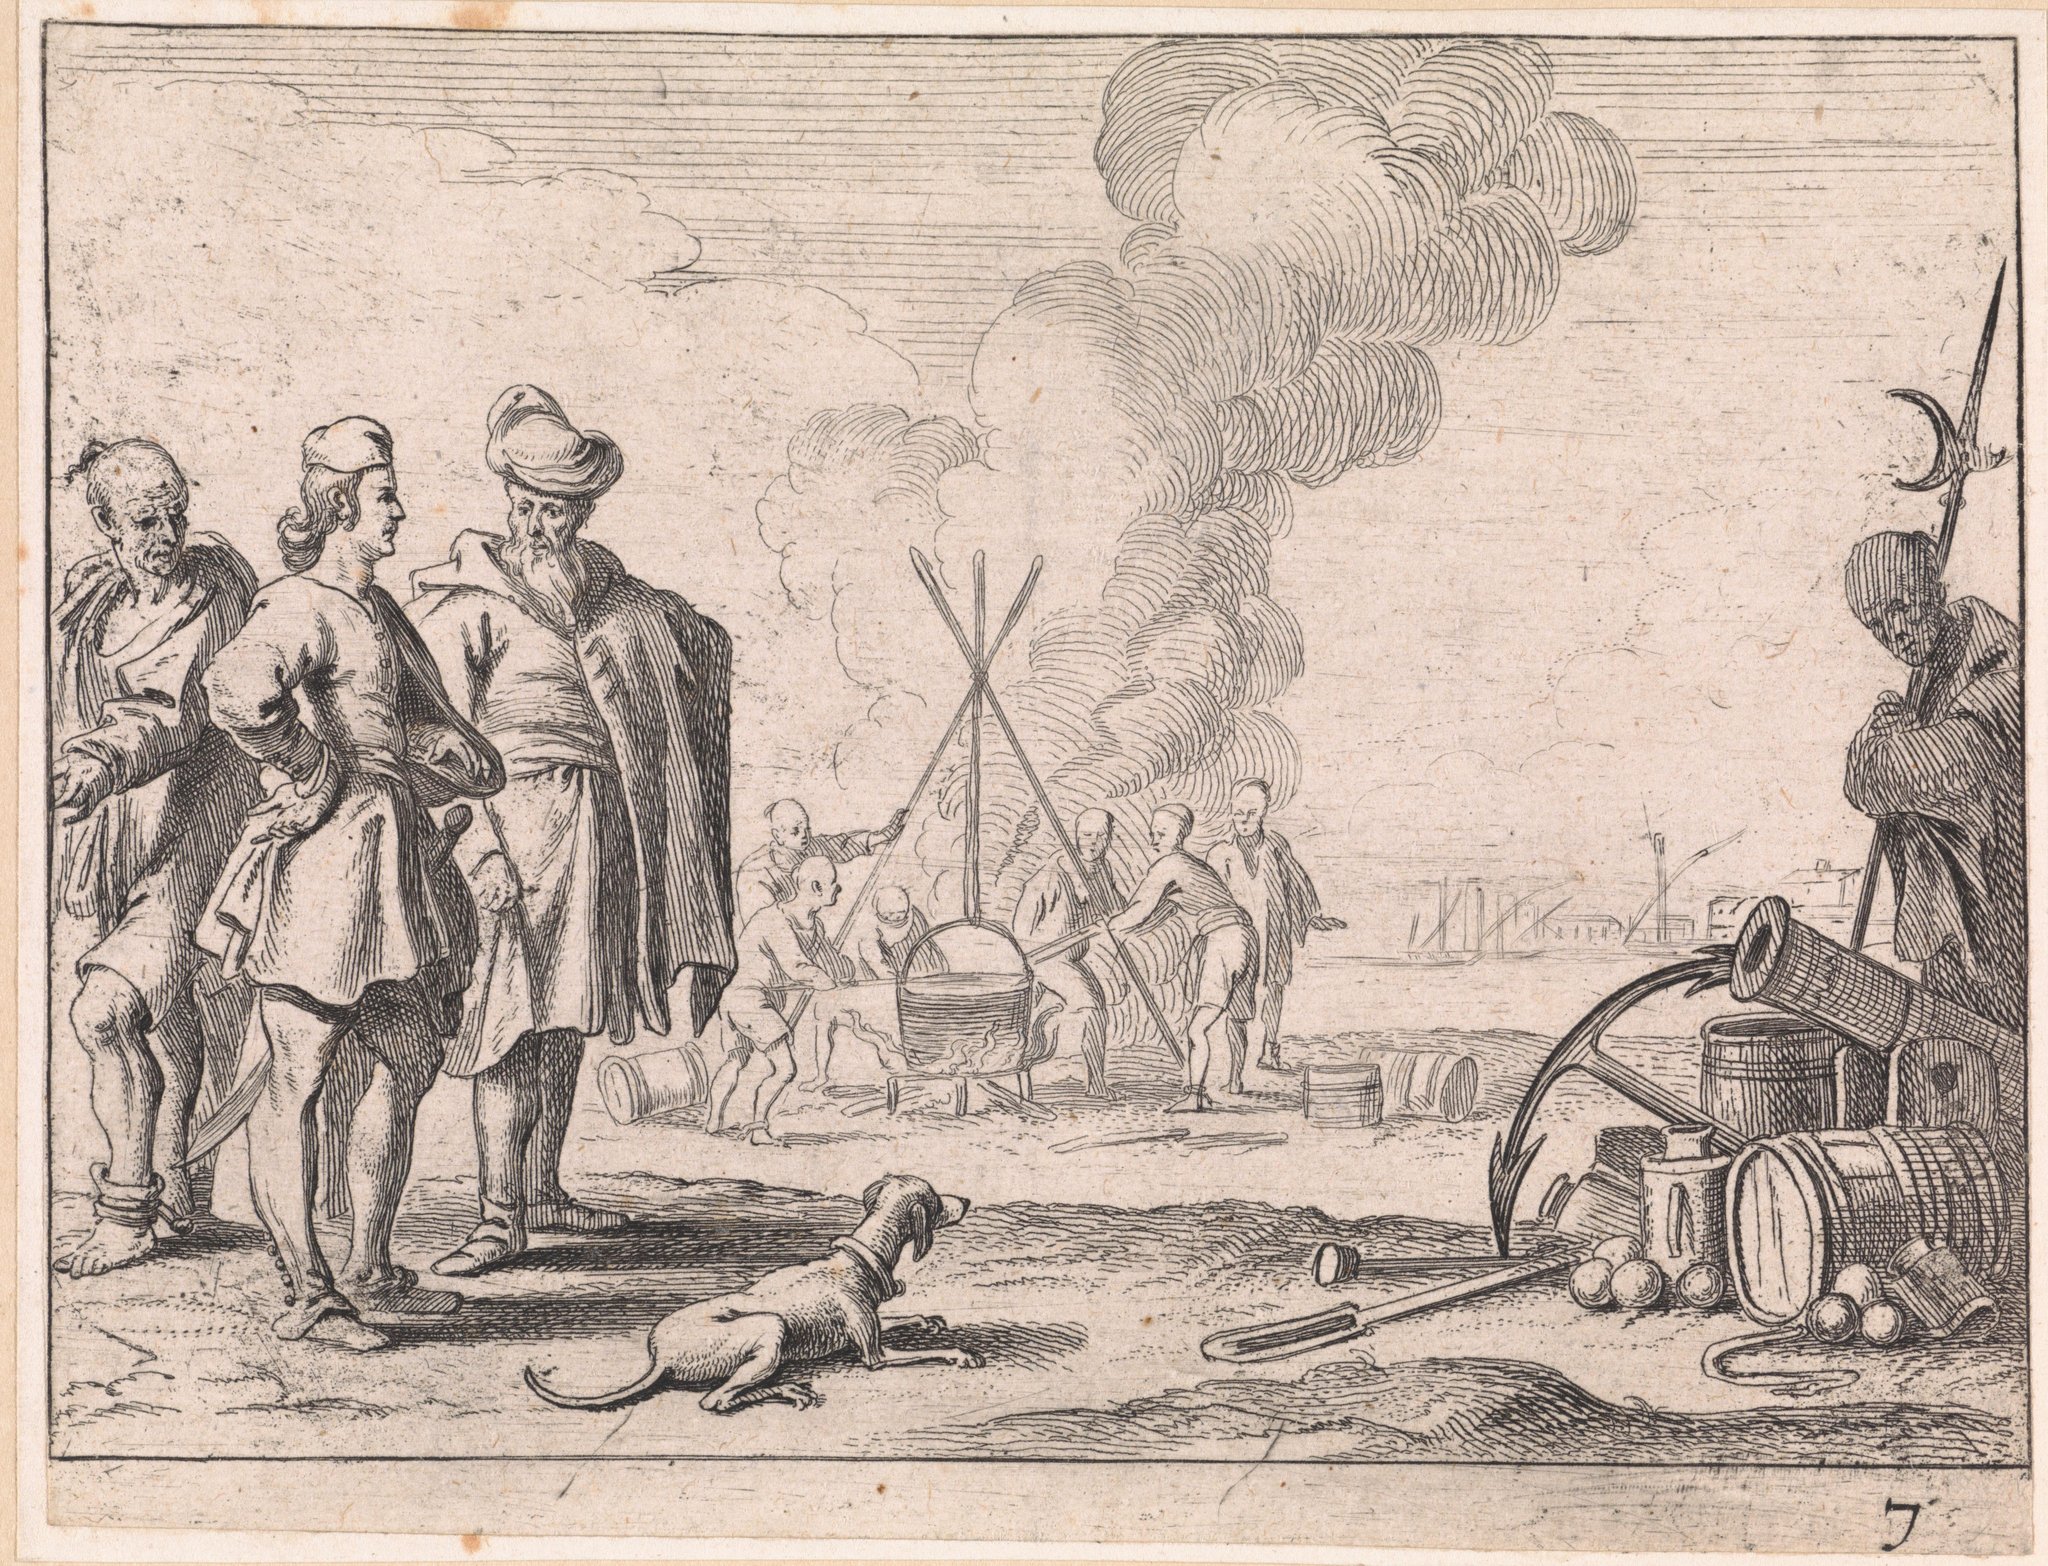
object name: print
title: Havens met slaven en zeelieden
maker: cornelis de wael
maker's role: draughtsman, print maker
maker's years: 1592-1667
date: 1647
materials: paper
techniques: engraving, etching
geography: genoa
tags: kitchen-utensils: cauldron, slavery; serfs and enslaved persons, repairing, caulking, careening (~ ship), seaman, beach, dog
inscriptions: collector's mark: Lugt 240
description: Links staat een islamitische galeislaaf naast een zeeman die in gesprek is met een papasso (moellah en vertegenwoordiger van de islamitische tot slaaf gemaakten). Voor hen een hond. Rechts een islamitische galeislaaf die een hellebaard vasthoudt. Voor hem een kanon, kogels, vaten, een anker en een roeispaan. Op de achtergrond islamitische galeislaven rond een ketel, waarschijnlijk ter voorbereiding van het breeuwen van een schip. Deze tot slaaf gemaakte mannen zijn als moslims te herkennen door het typerende kapsel (hoofd op een pluk na kaalgeschoren) dat zij verplicht waren te hebben.